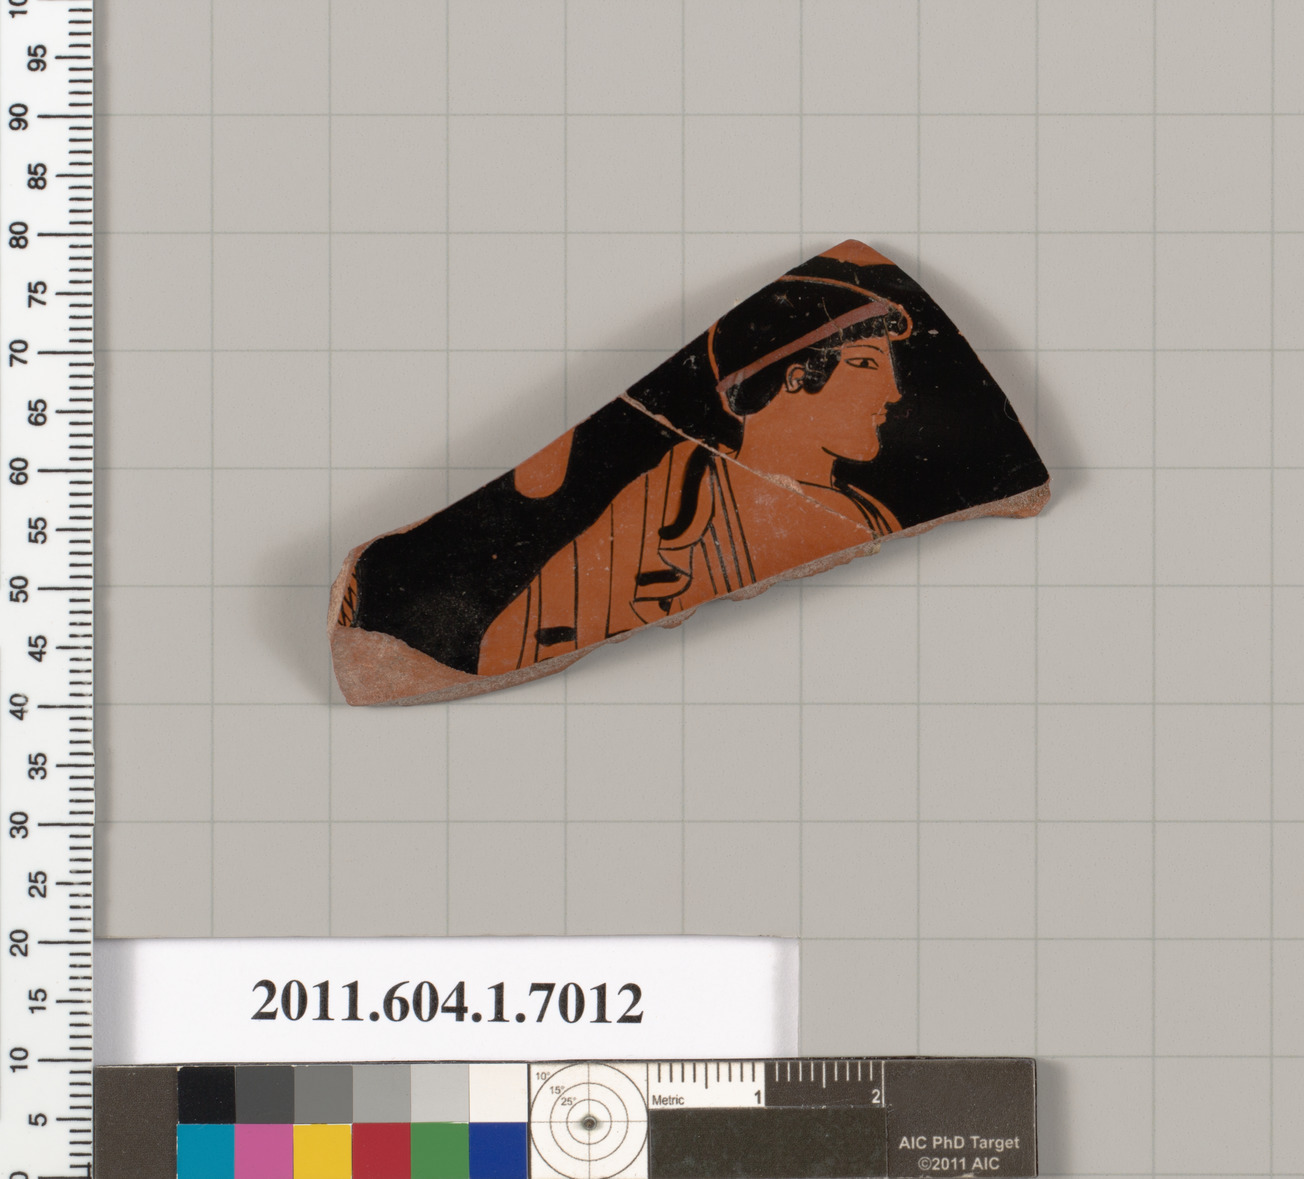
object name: kylix fragment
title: Terracotta fragment of a kylix (drinking cup)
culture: greek, attic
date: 500-490 BCE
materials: terracotta